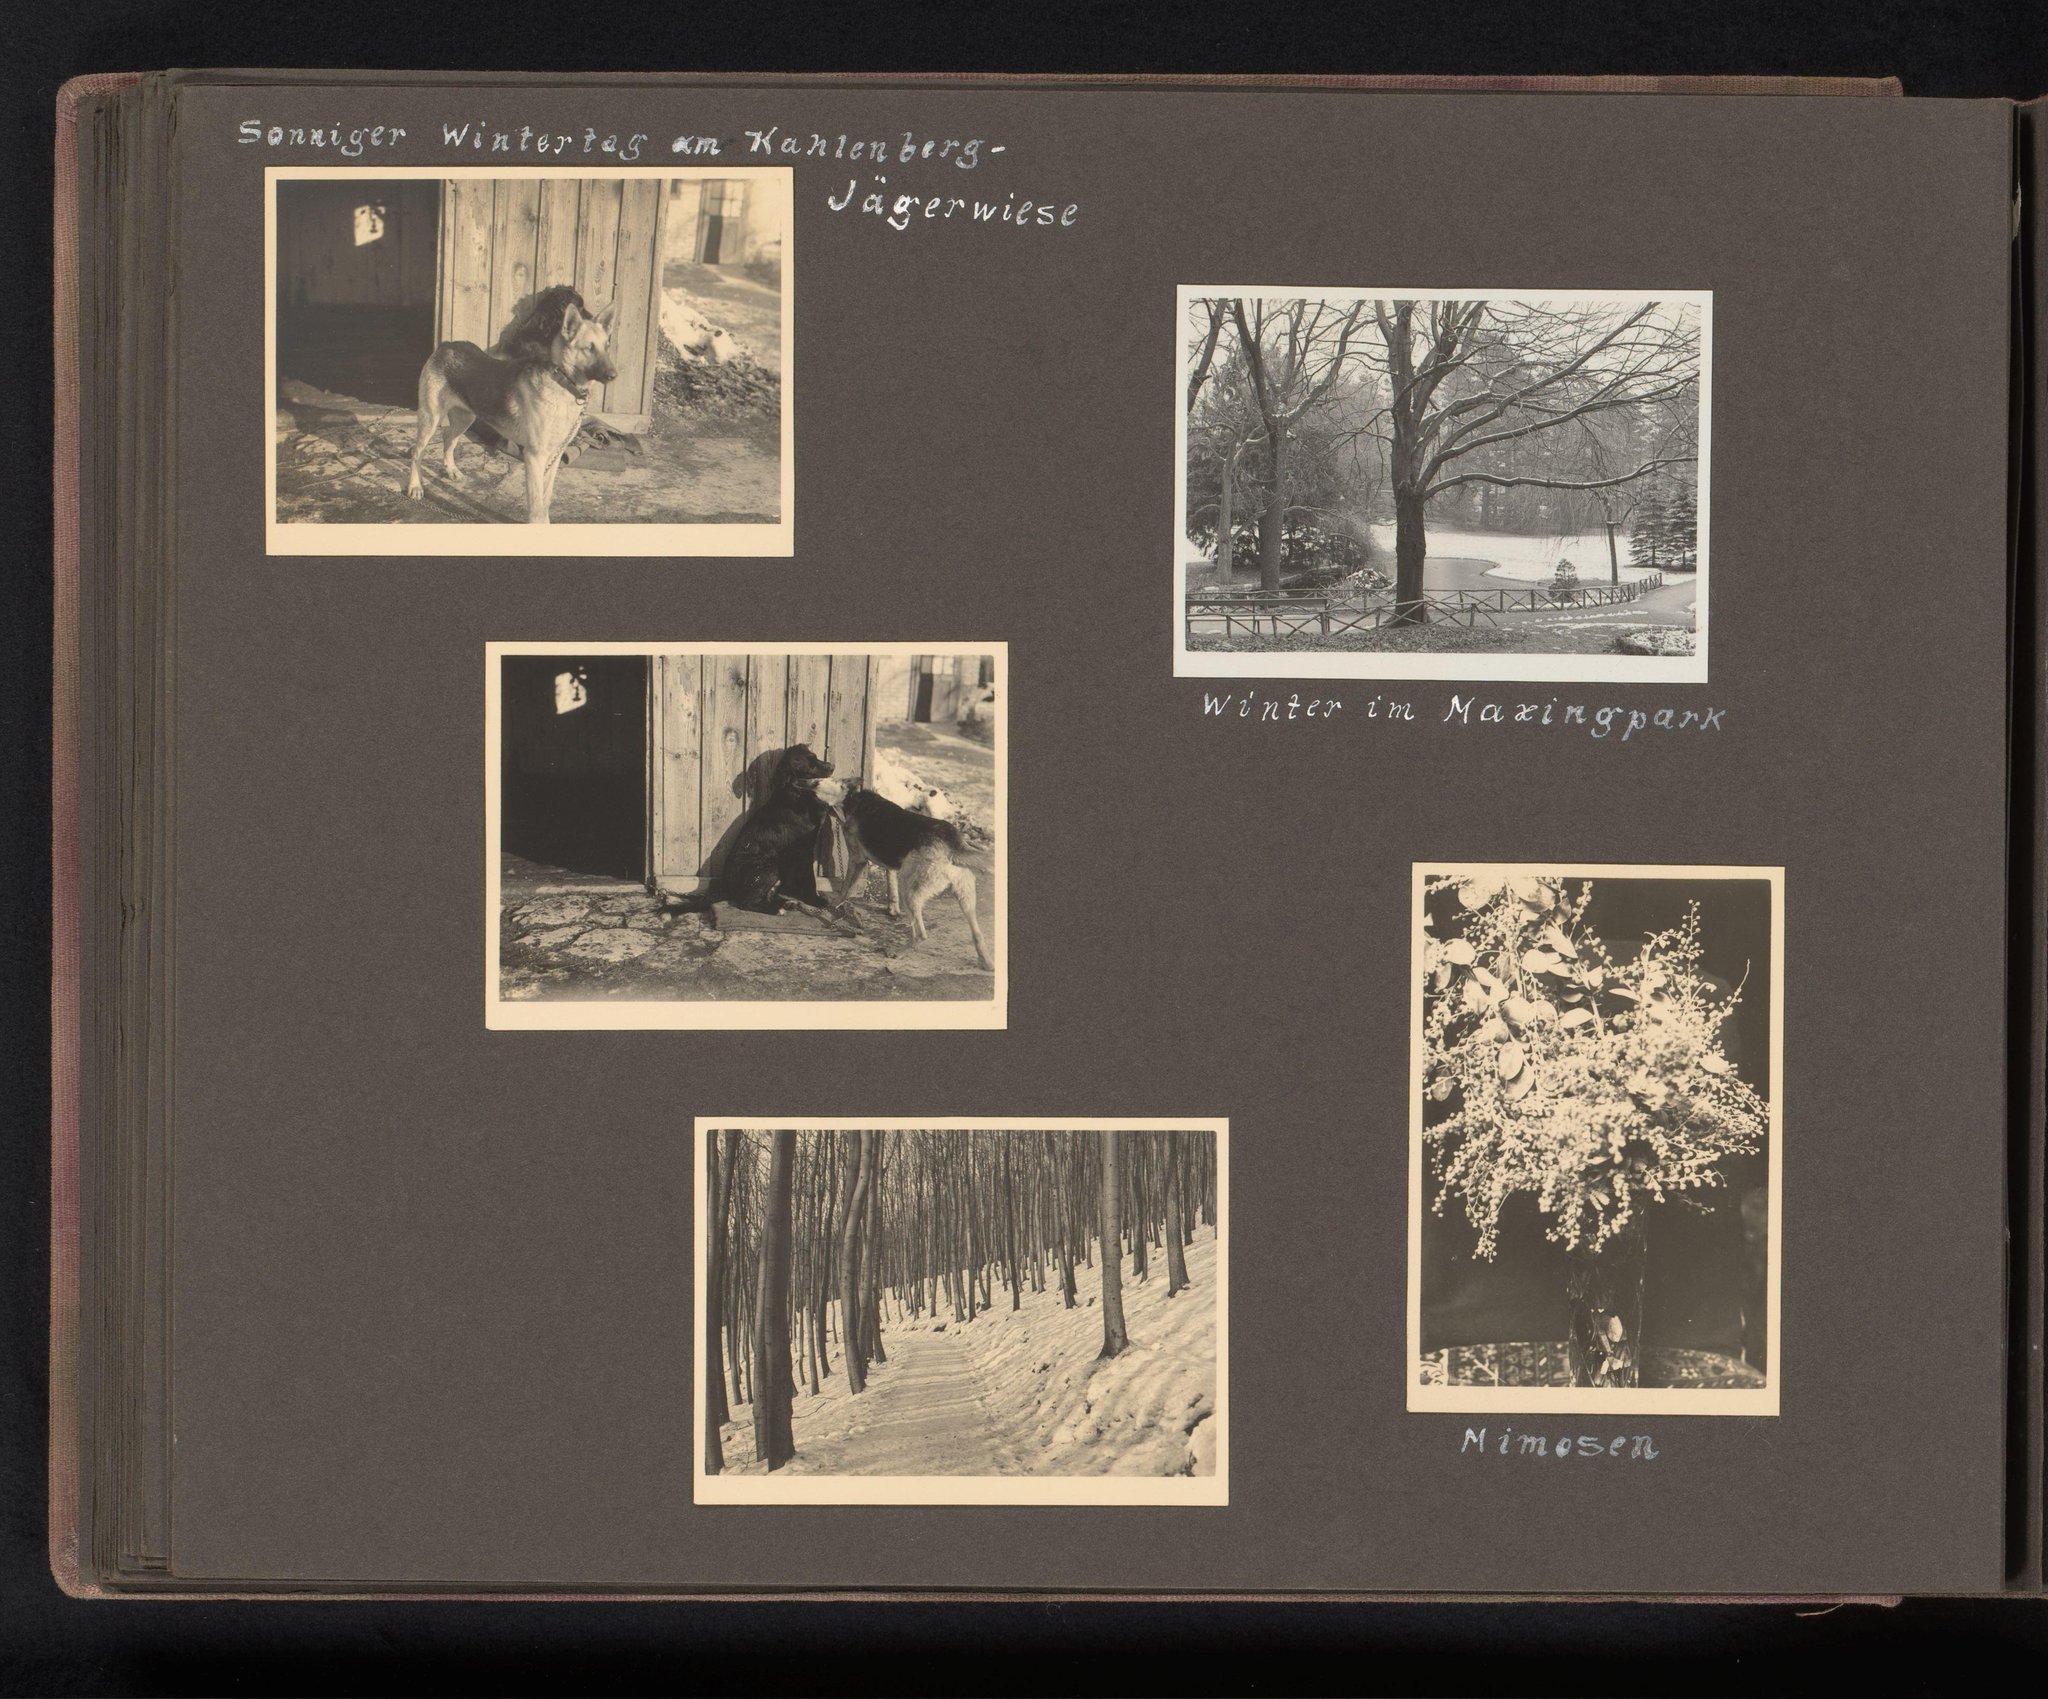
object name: photograph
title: Zonnige winterdag op de Kahlenberg in Wenen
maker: berti hoppe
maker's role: fotograaf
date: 1930-1931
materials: cardboard, photographic support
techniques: gelatin silver print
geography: vienna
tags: park, winter landscape; landscape symbolizing winter (the four seasons of the year), plants and herbs, dog, vienna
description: Twee foto's van honden voor een schuur, twee gezichten op een park in de sneeuw en een mimosa in een vaas. Deze foto's maken deel uit van een album.